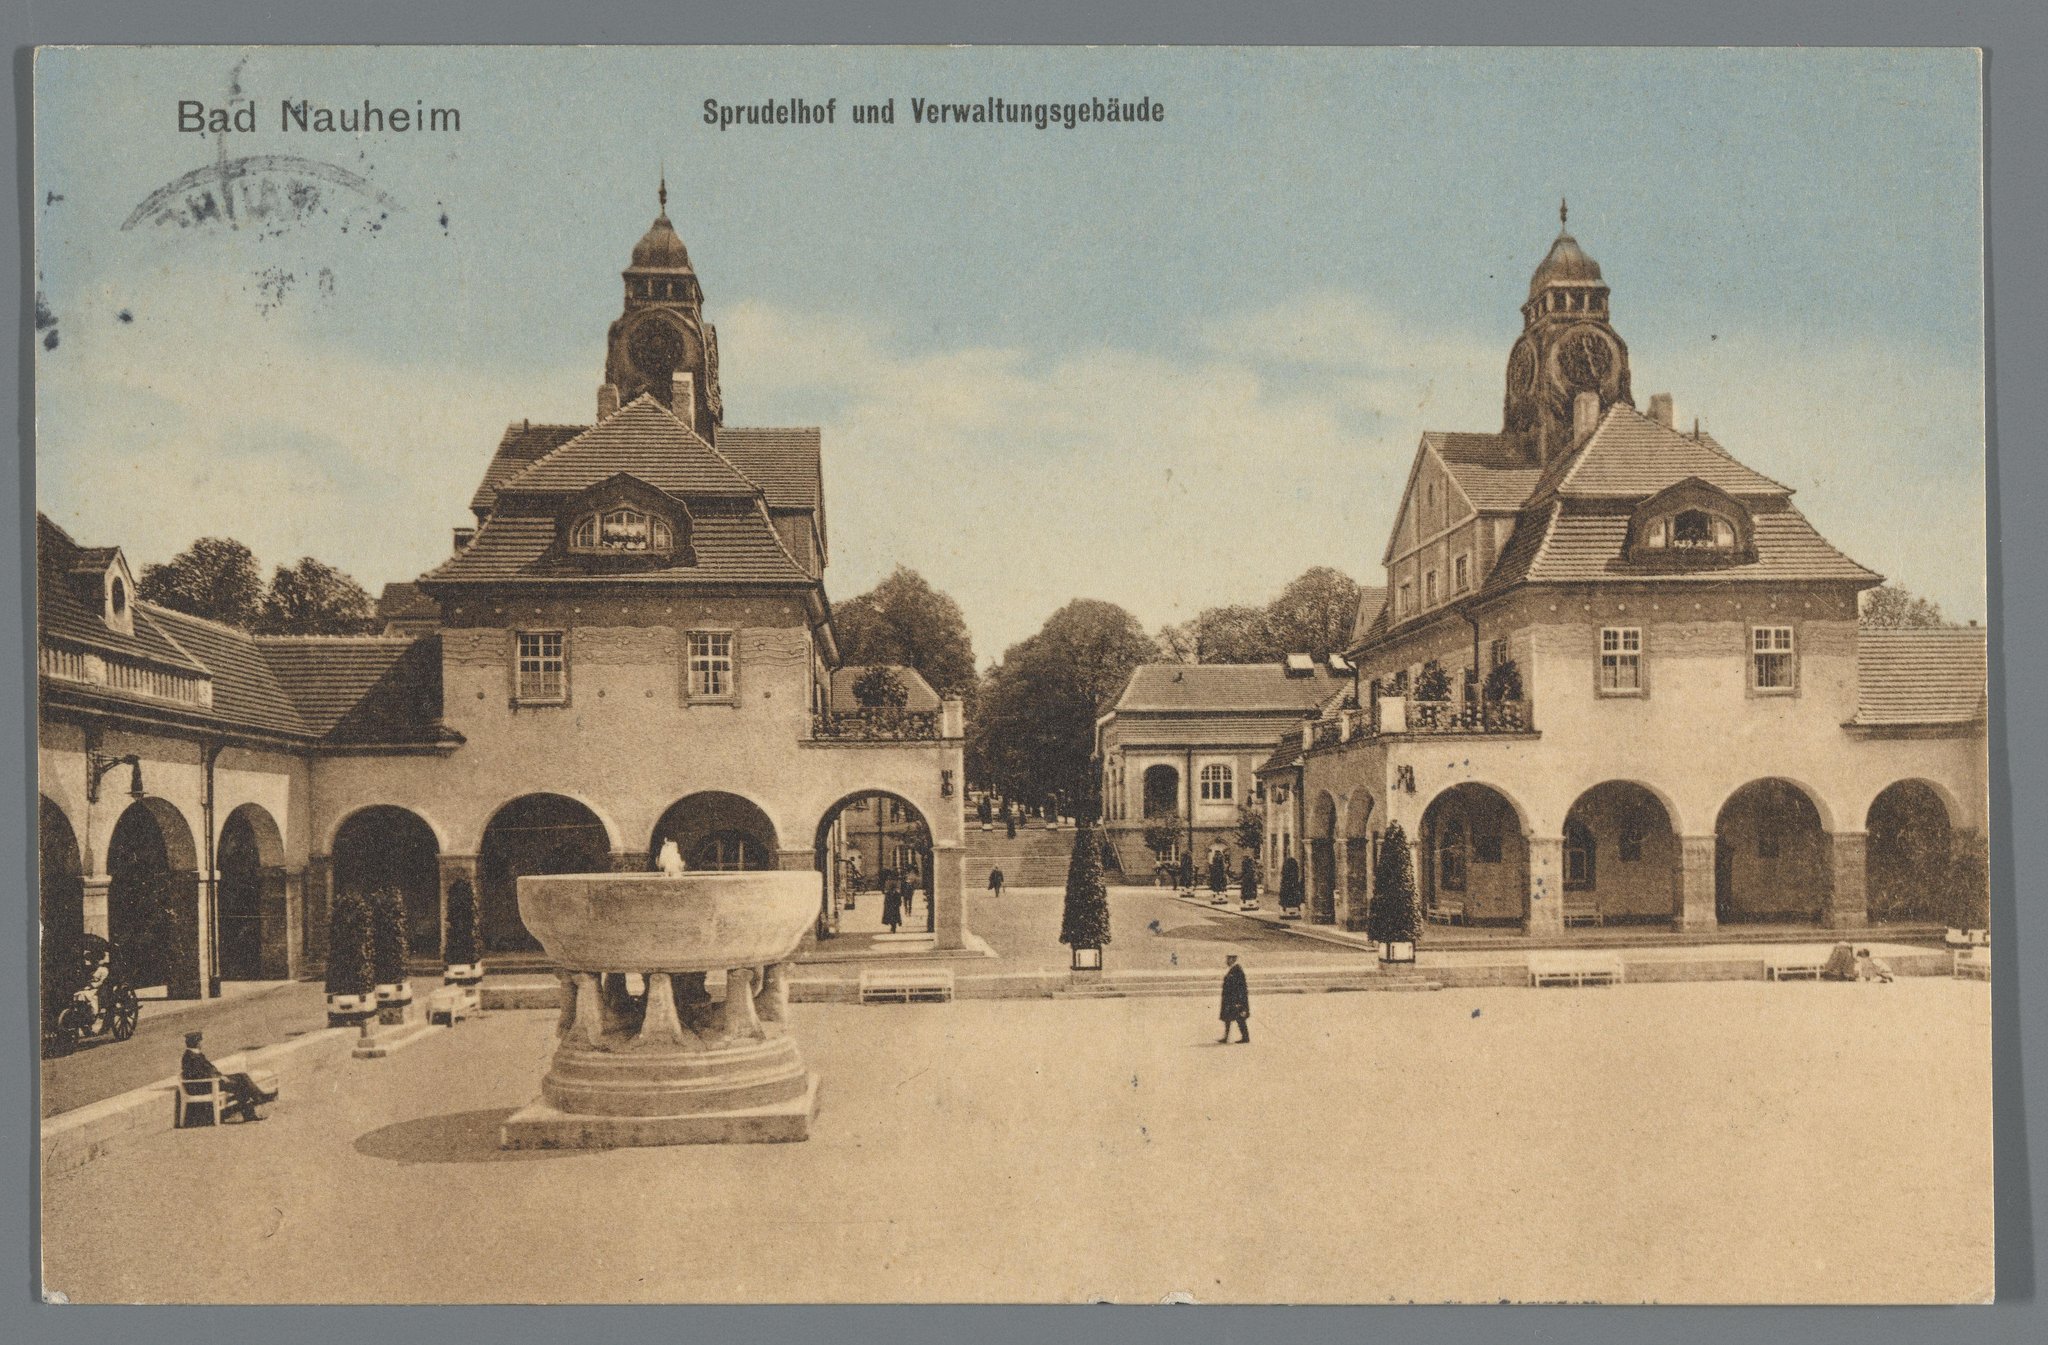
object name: postcard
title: Bad Nauheim. Sprudelhof und Verwaltungsgebäude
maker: Anonymous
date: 1900-1925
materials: photographic support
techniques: photograph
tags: bad nauheim